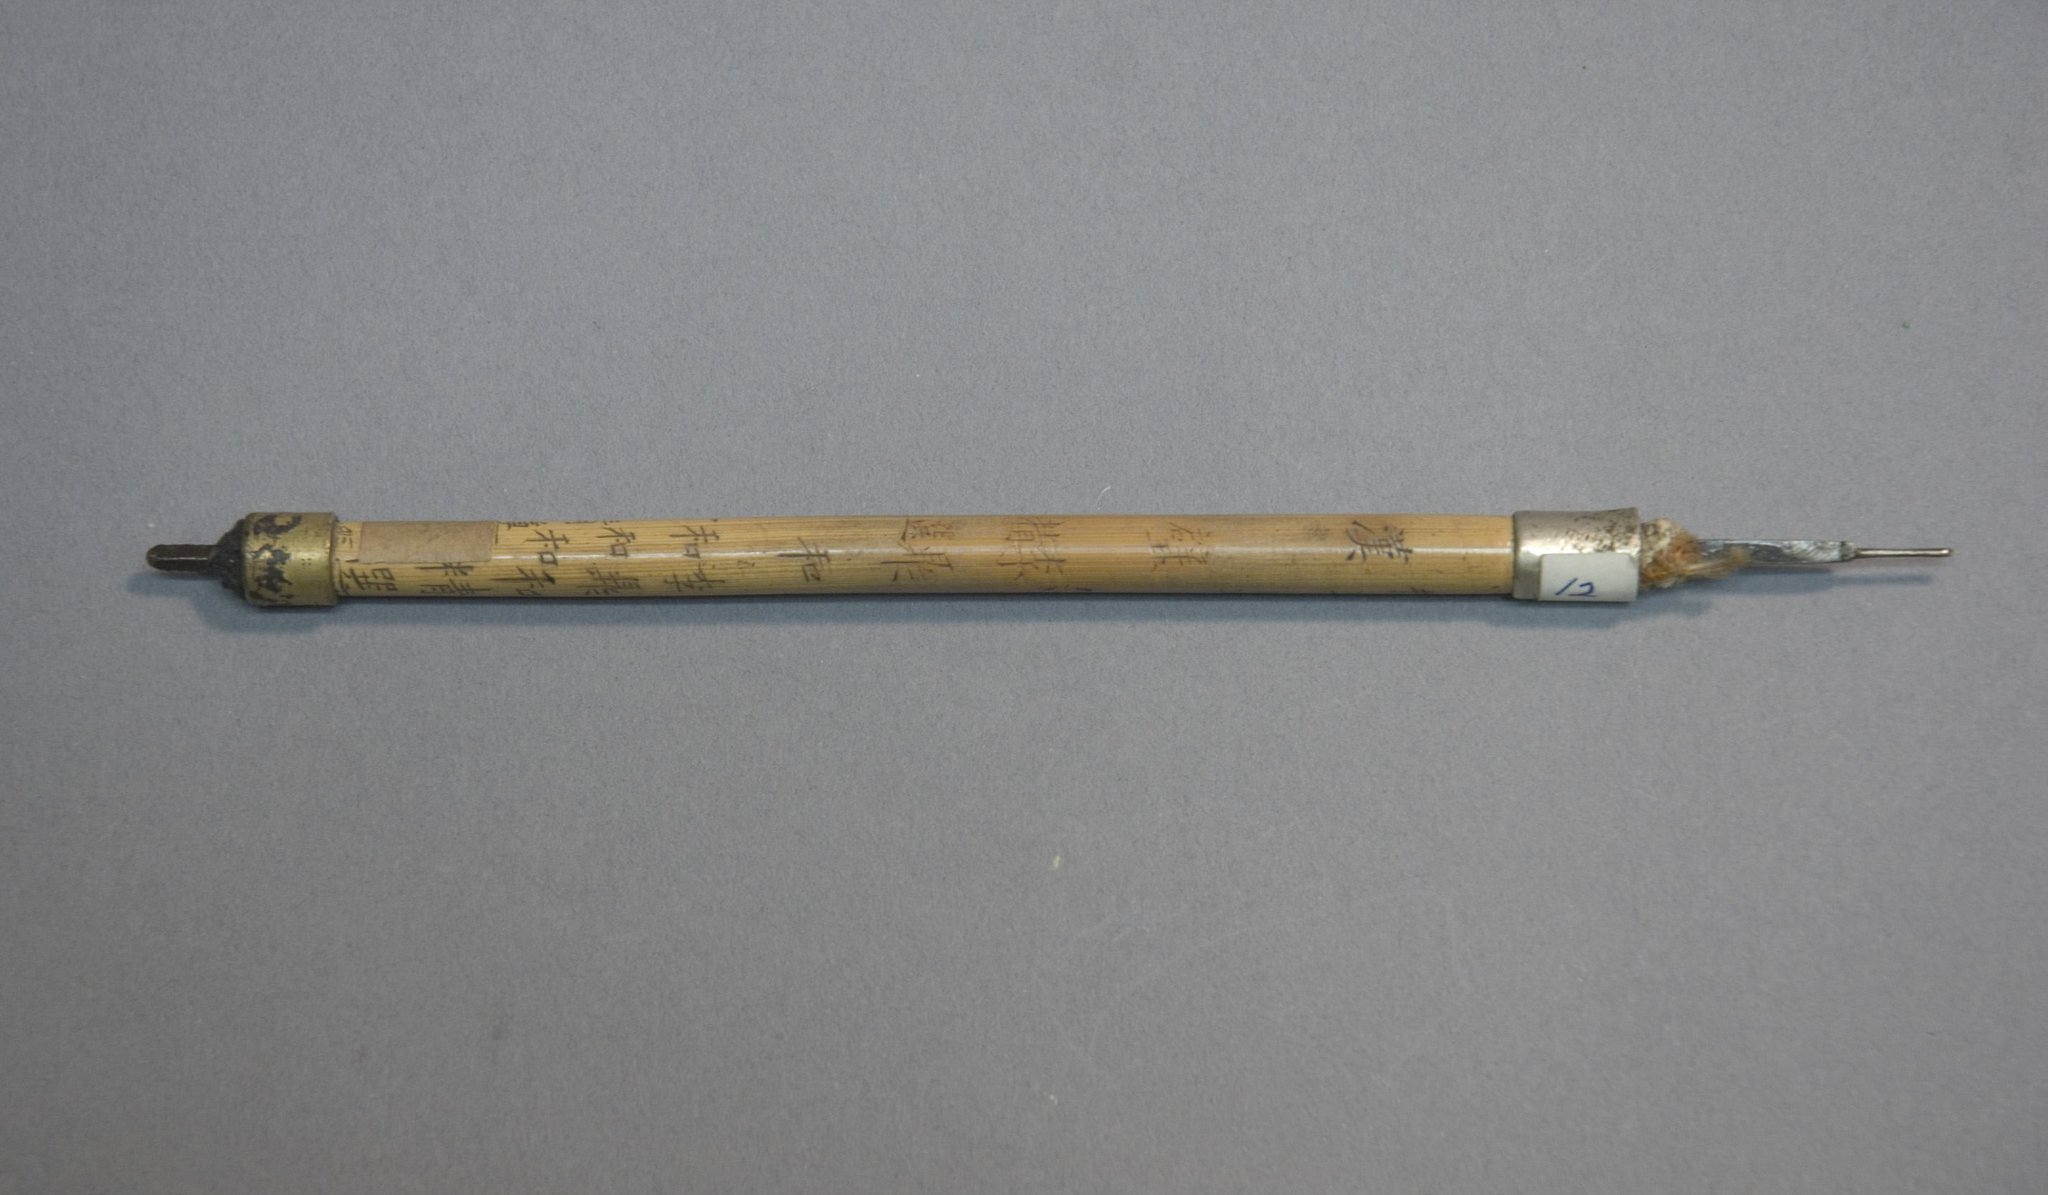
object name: jade carving tool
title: Diamond-Point for Carving Jade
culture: chinese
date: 1901-2000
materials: metal, wood